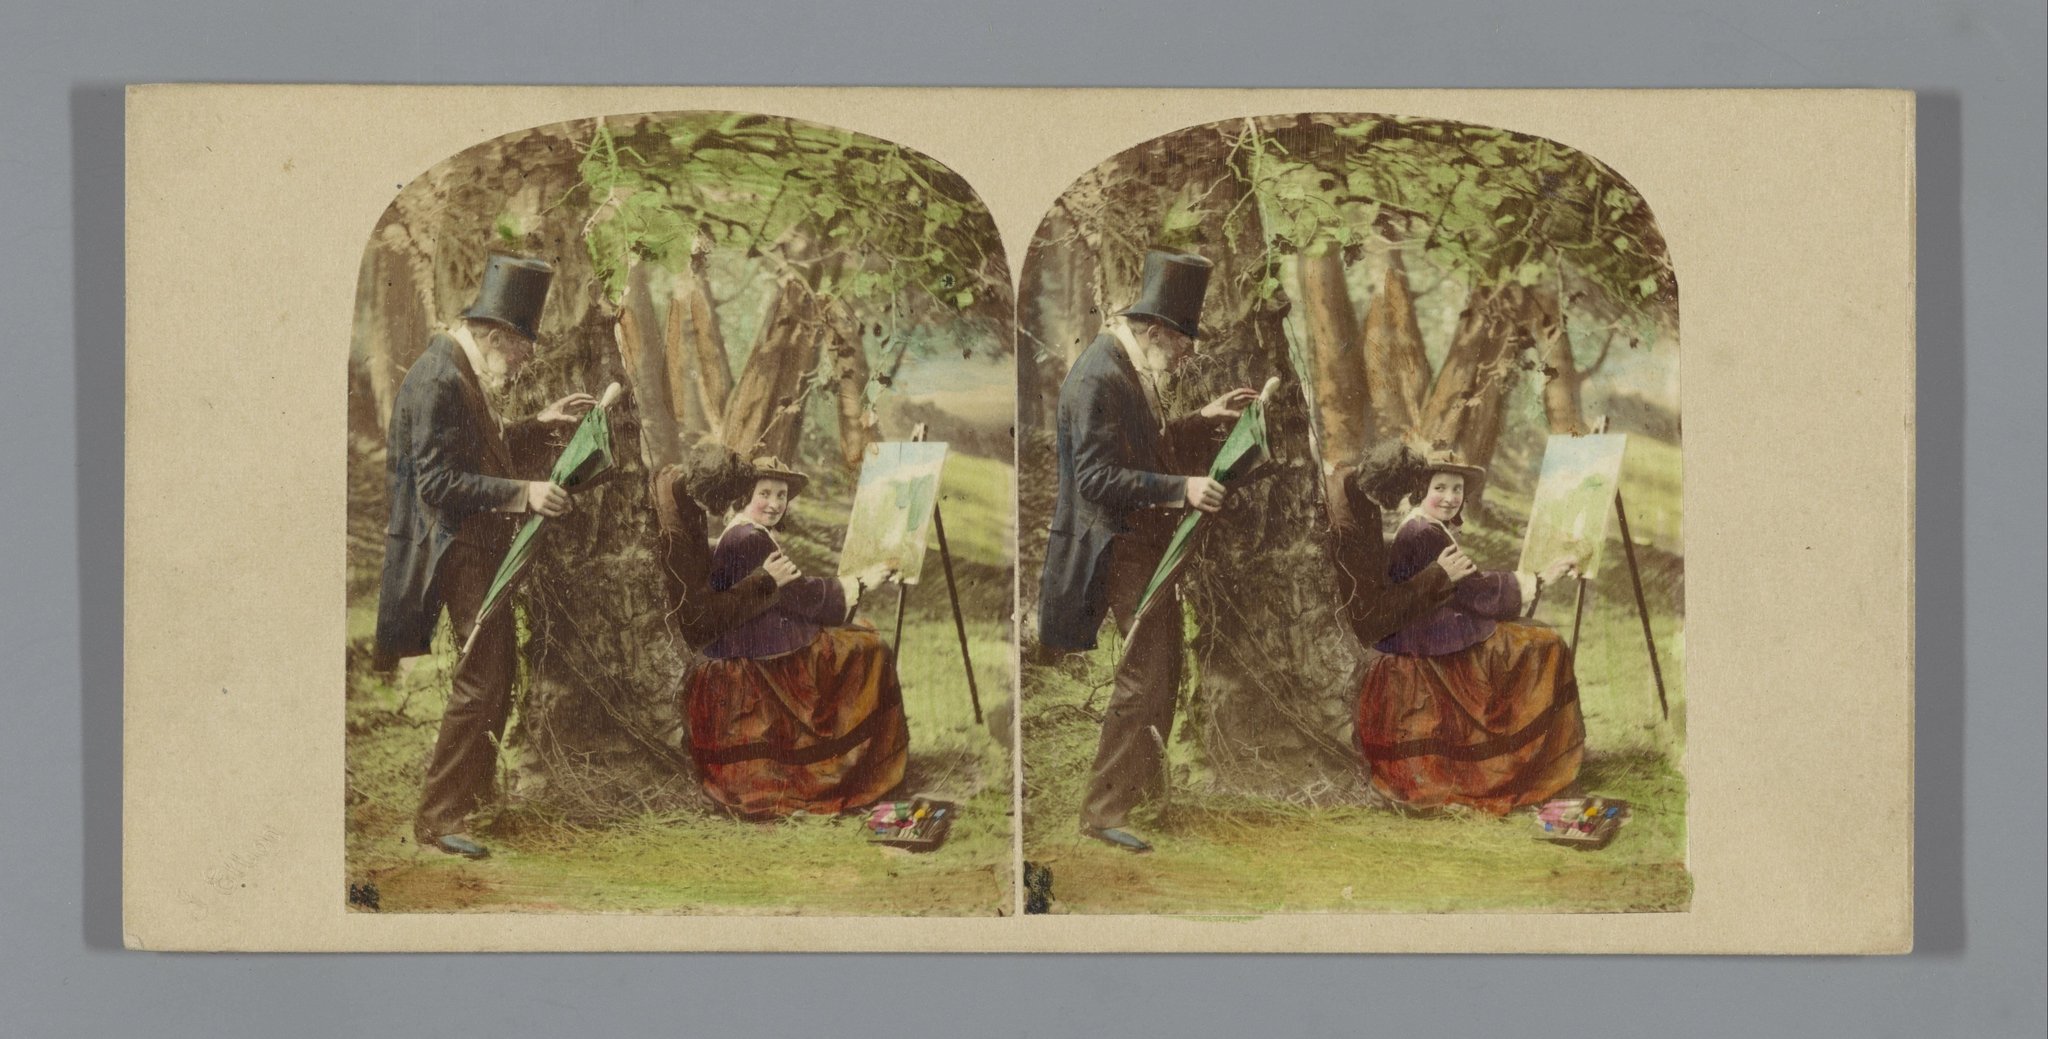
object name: stereograph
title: Very pretty indeed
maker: james elliott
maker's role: publisher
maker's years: 1832-1900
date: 1856-1861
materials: cardboard, paper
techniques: albumen print, hand coloring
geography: london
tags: easel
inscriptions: inscription: ‘dn Fr 80 [onz]’, inscription: ‘Entered at Stationers' Hall.’